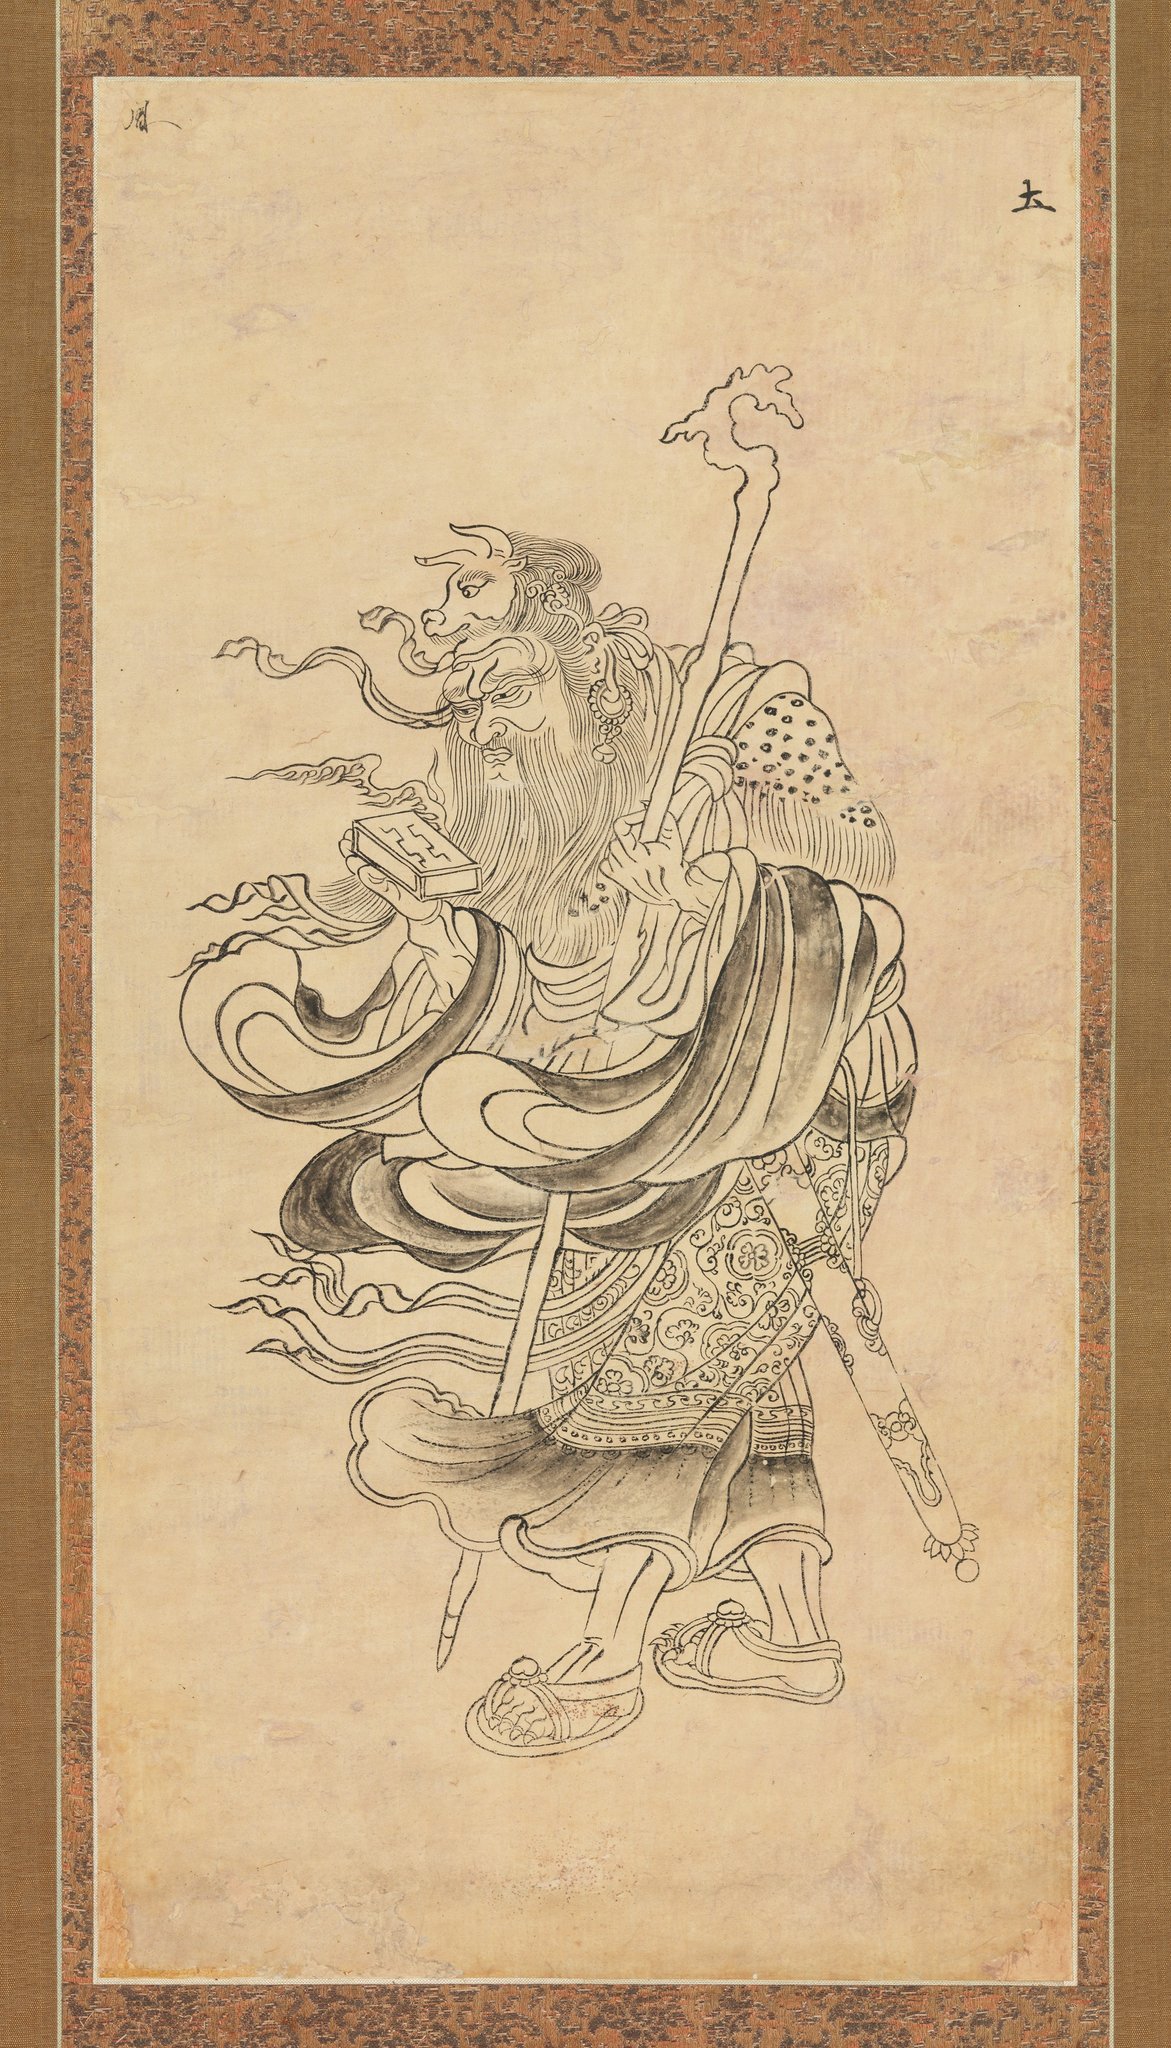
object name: hanging scroll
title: Iconographic Drawing of Saturn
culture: japanese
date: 1101-1200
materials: ink, paper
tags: men